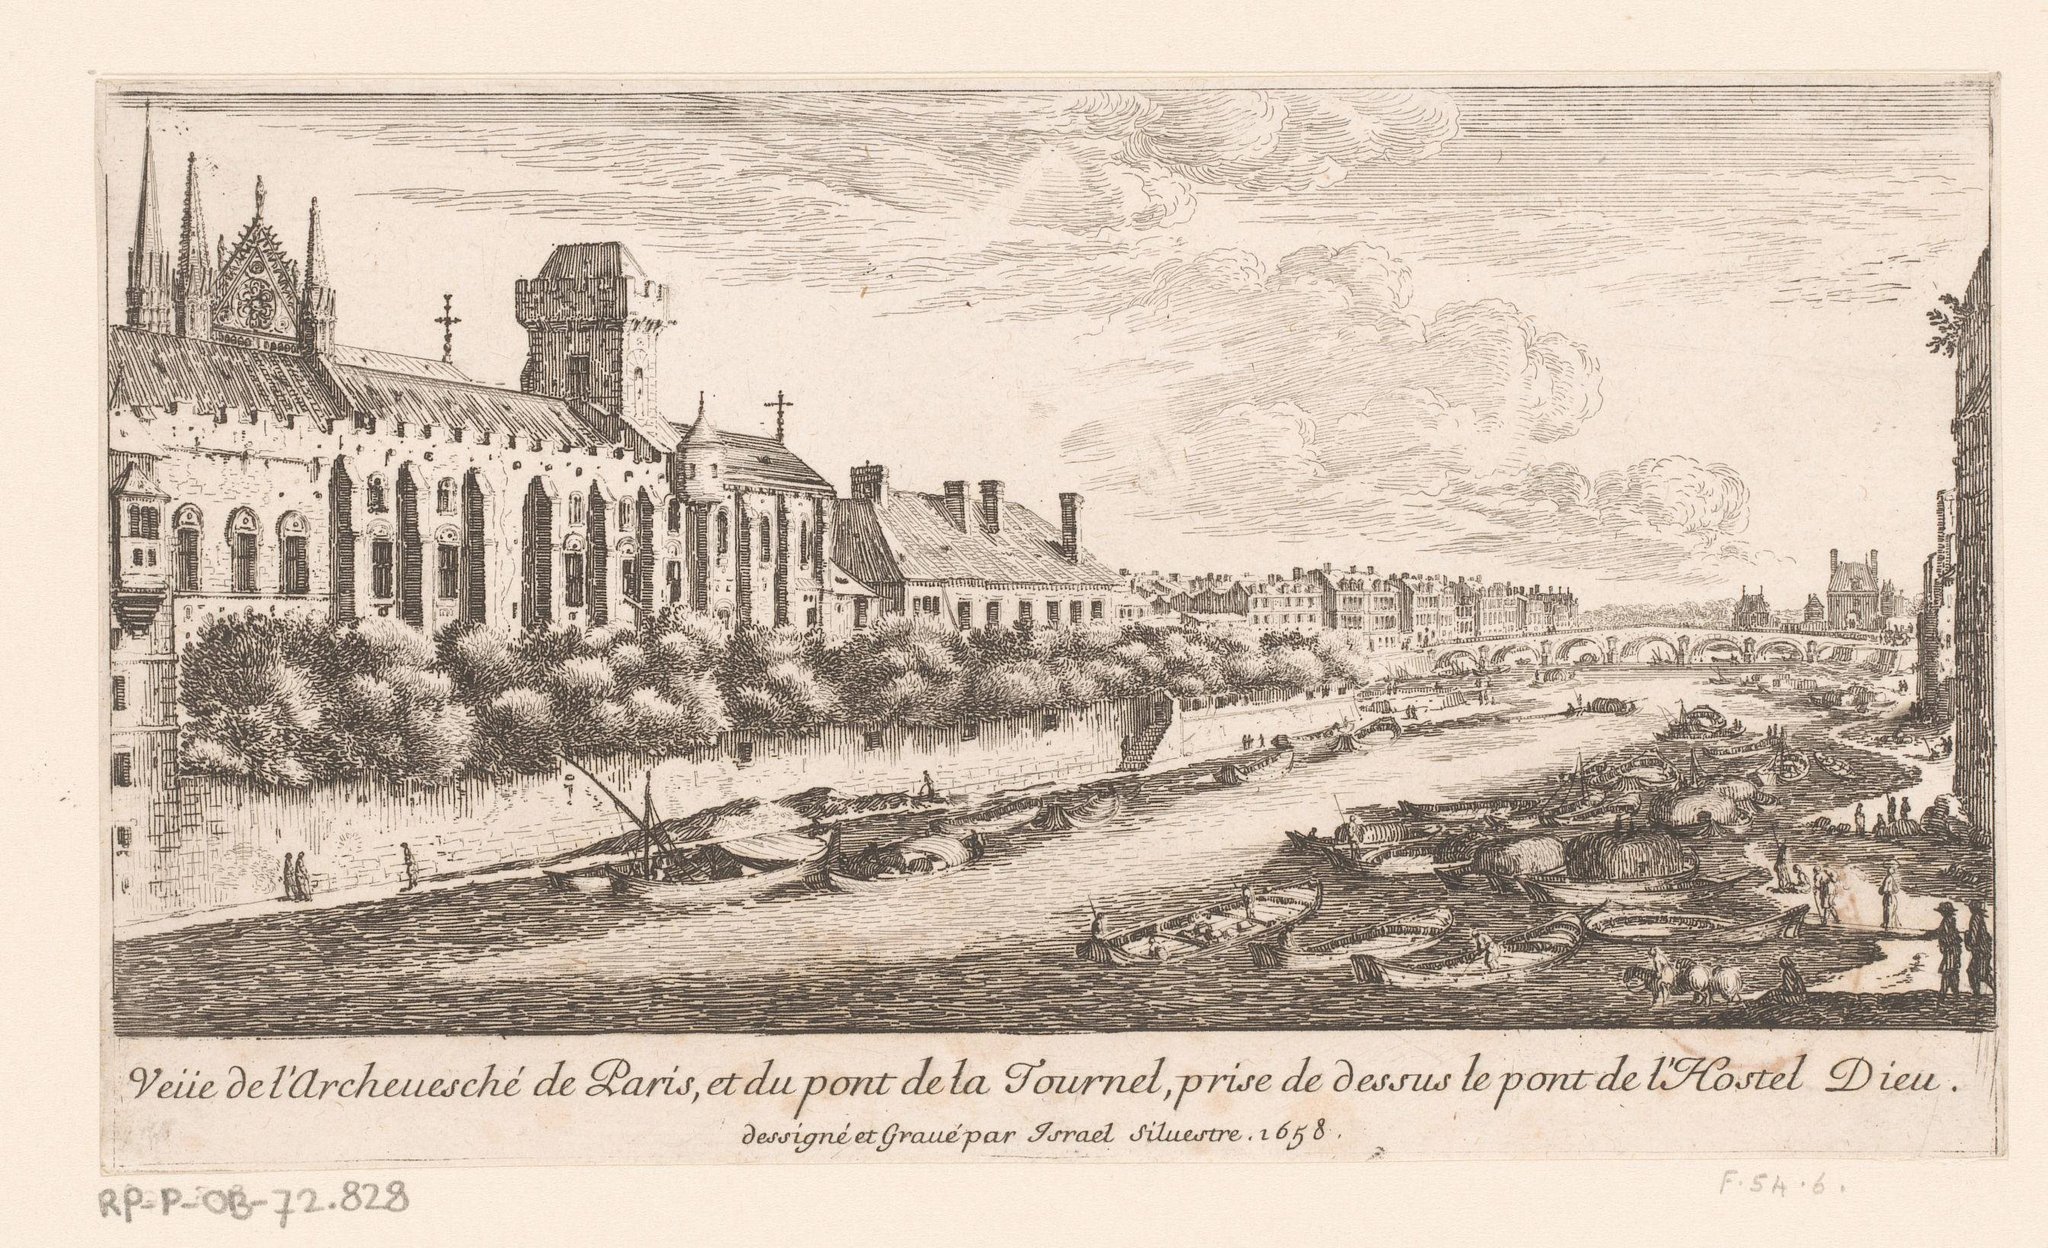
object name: print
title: Veue de l'Archevesché de Paris et du Pont de la Tournel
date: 1658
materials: paper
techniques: etching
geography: france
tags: landscape with tower or castle (+ city(-scape) with figures, staffage)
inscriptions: collector's mark: Lugt 240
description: Prent maakt deel uit van een ongenummerde serie van tien prenten.